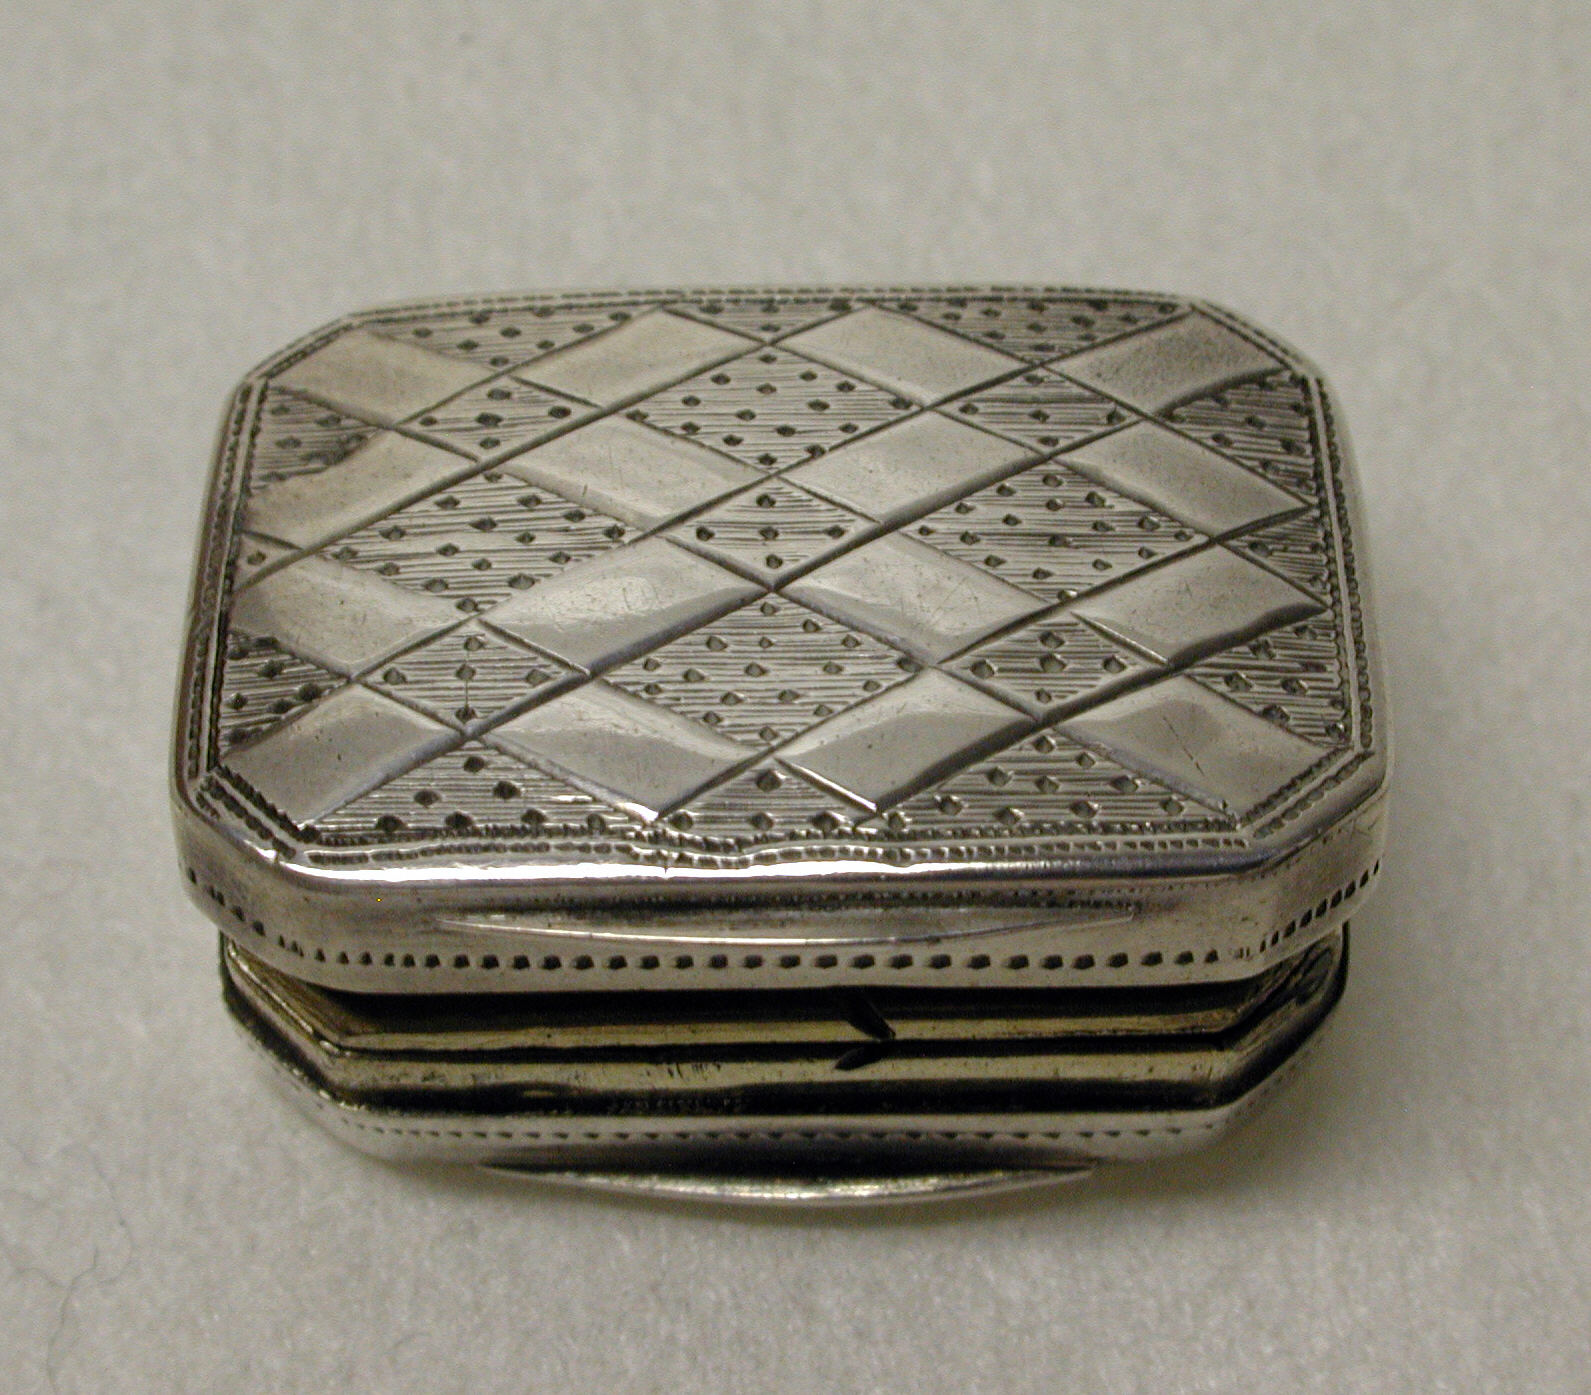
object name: vinaigrette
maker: matthew boulton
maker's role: maker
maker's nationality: british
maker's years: 1728-1809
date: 1808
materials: silver